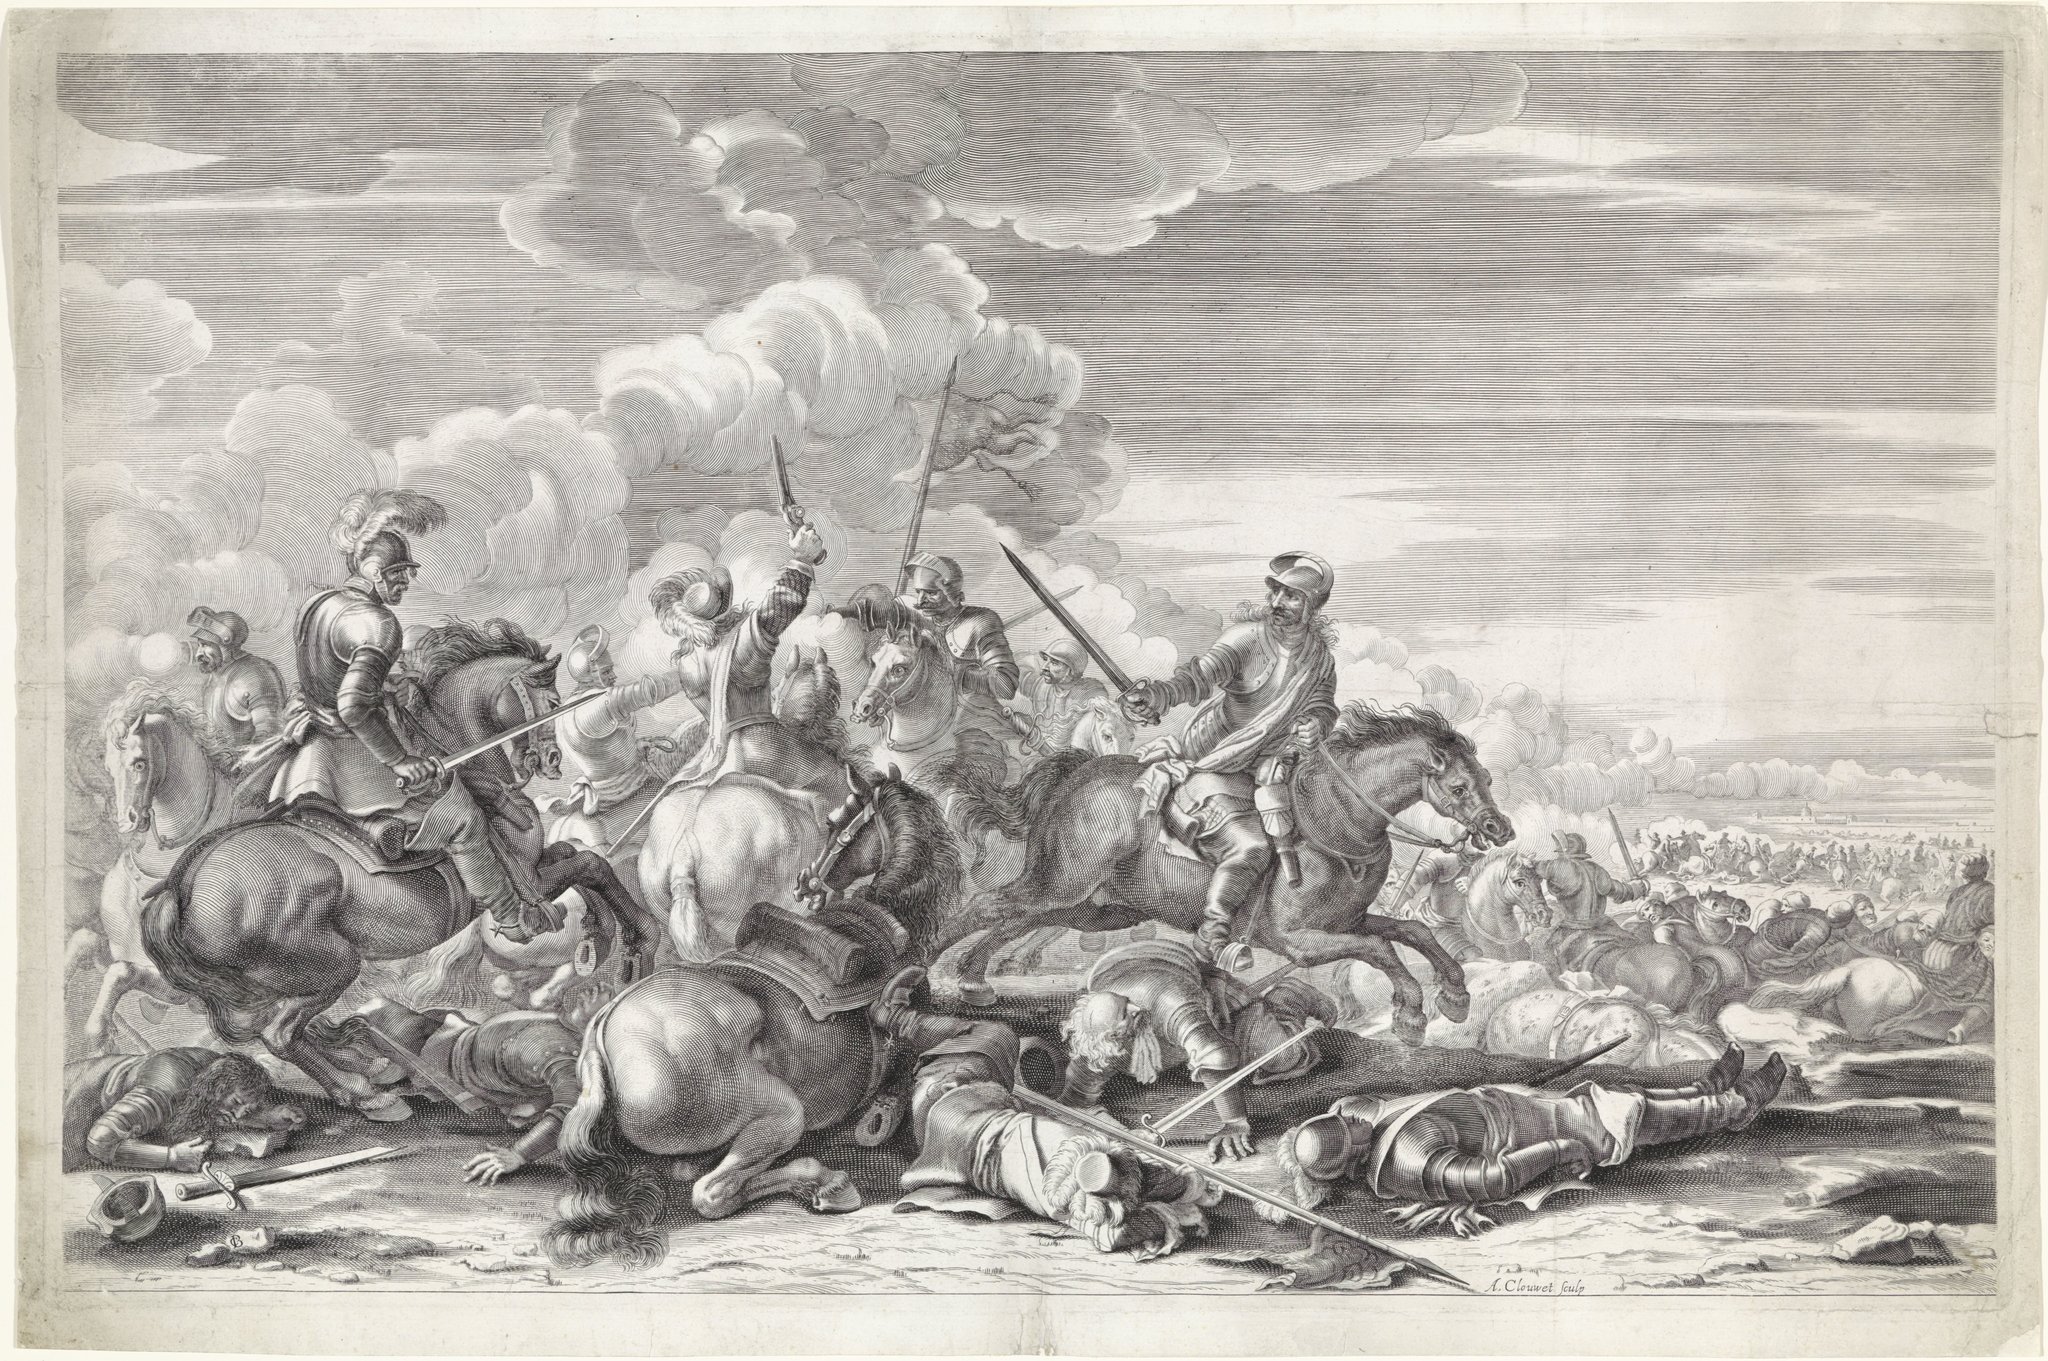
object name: print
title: Cavaleriegevecht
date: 1646-1679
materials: paper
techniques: engraving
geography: rome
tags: battle (+ cavalry, horsemen)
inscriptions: collector's mark: Lugt 240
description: Een slagveld. Op de voorgrond vechten twee cavalerie-eenheden een schermutseling uit. Verschillende ruiters zijn al gesneuveld.